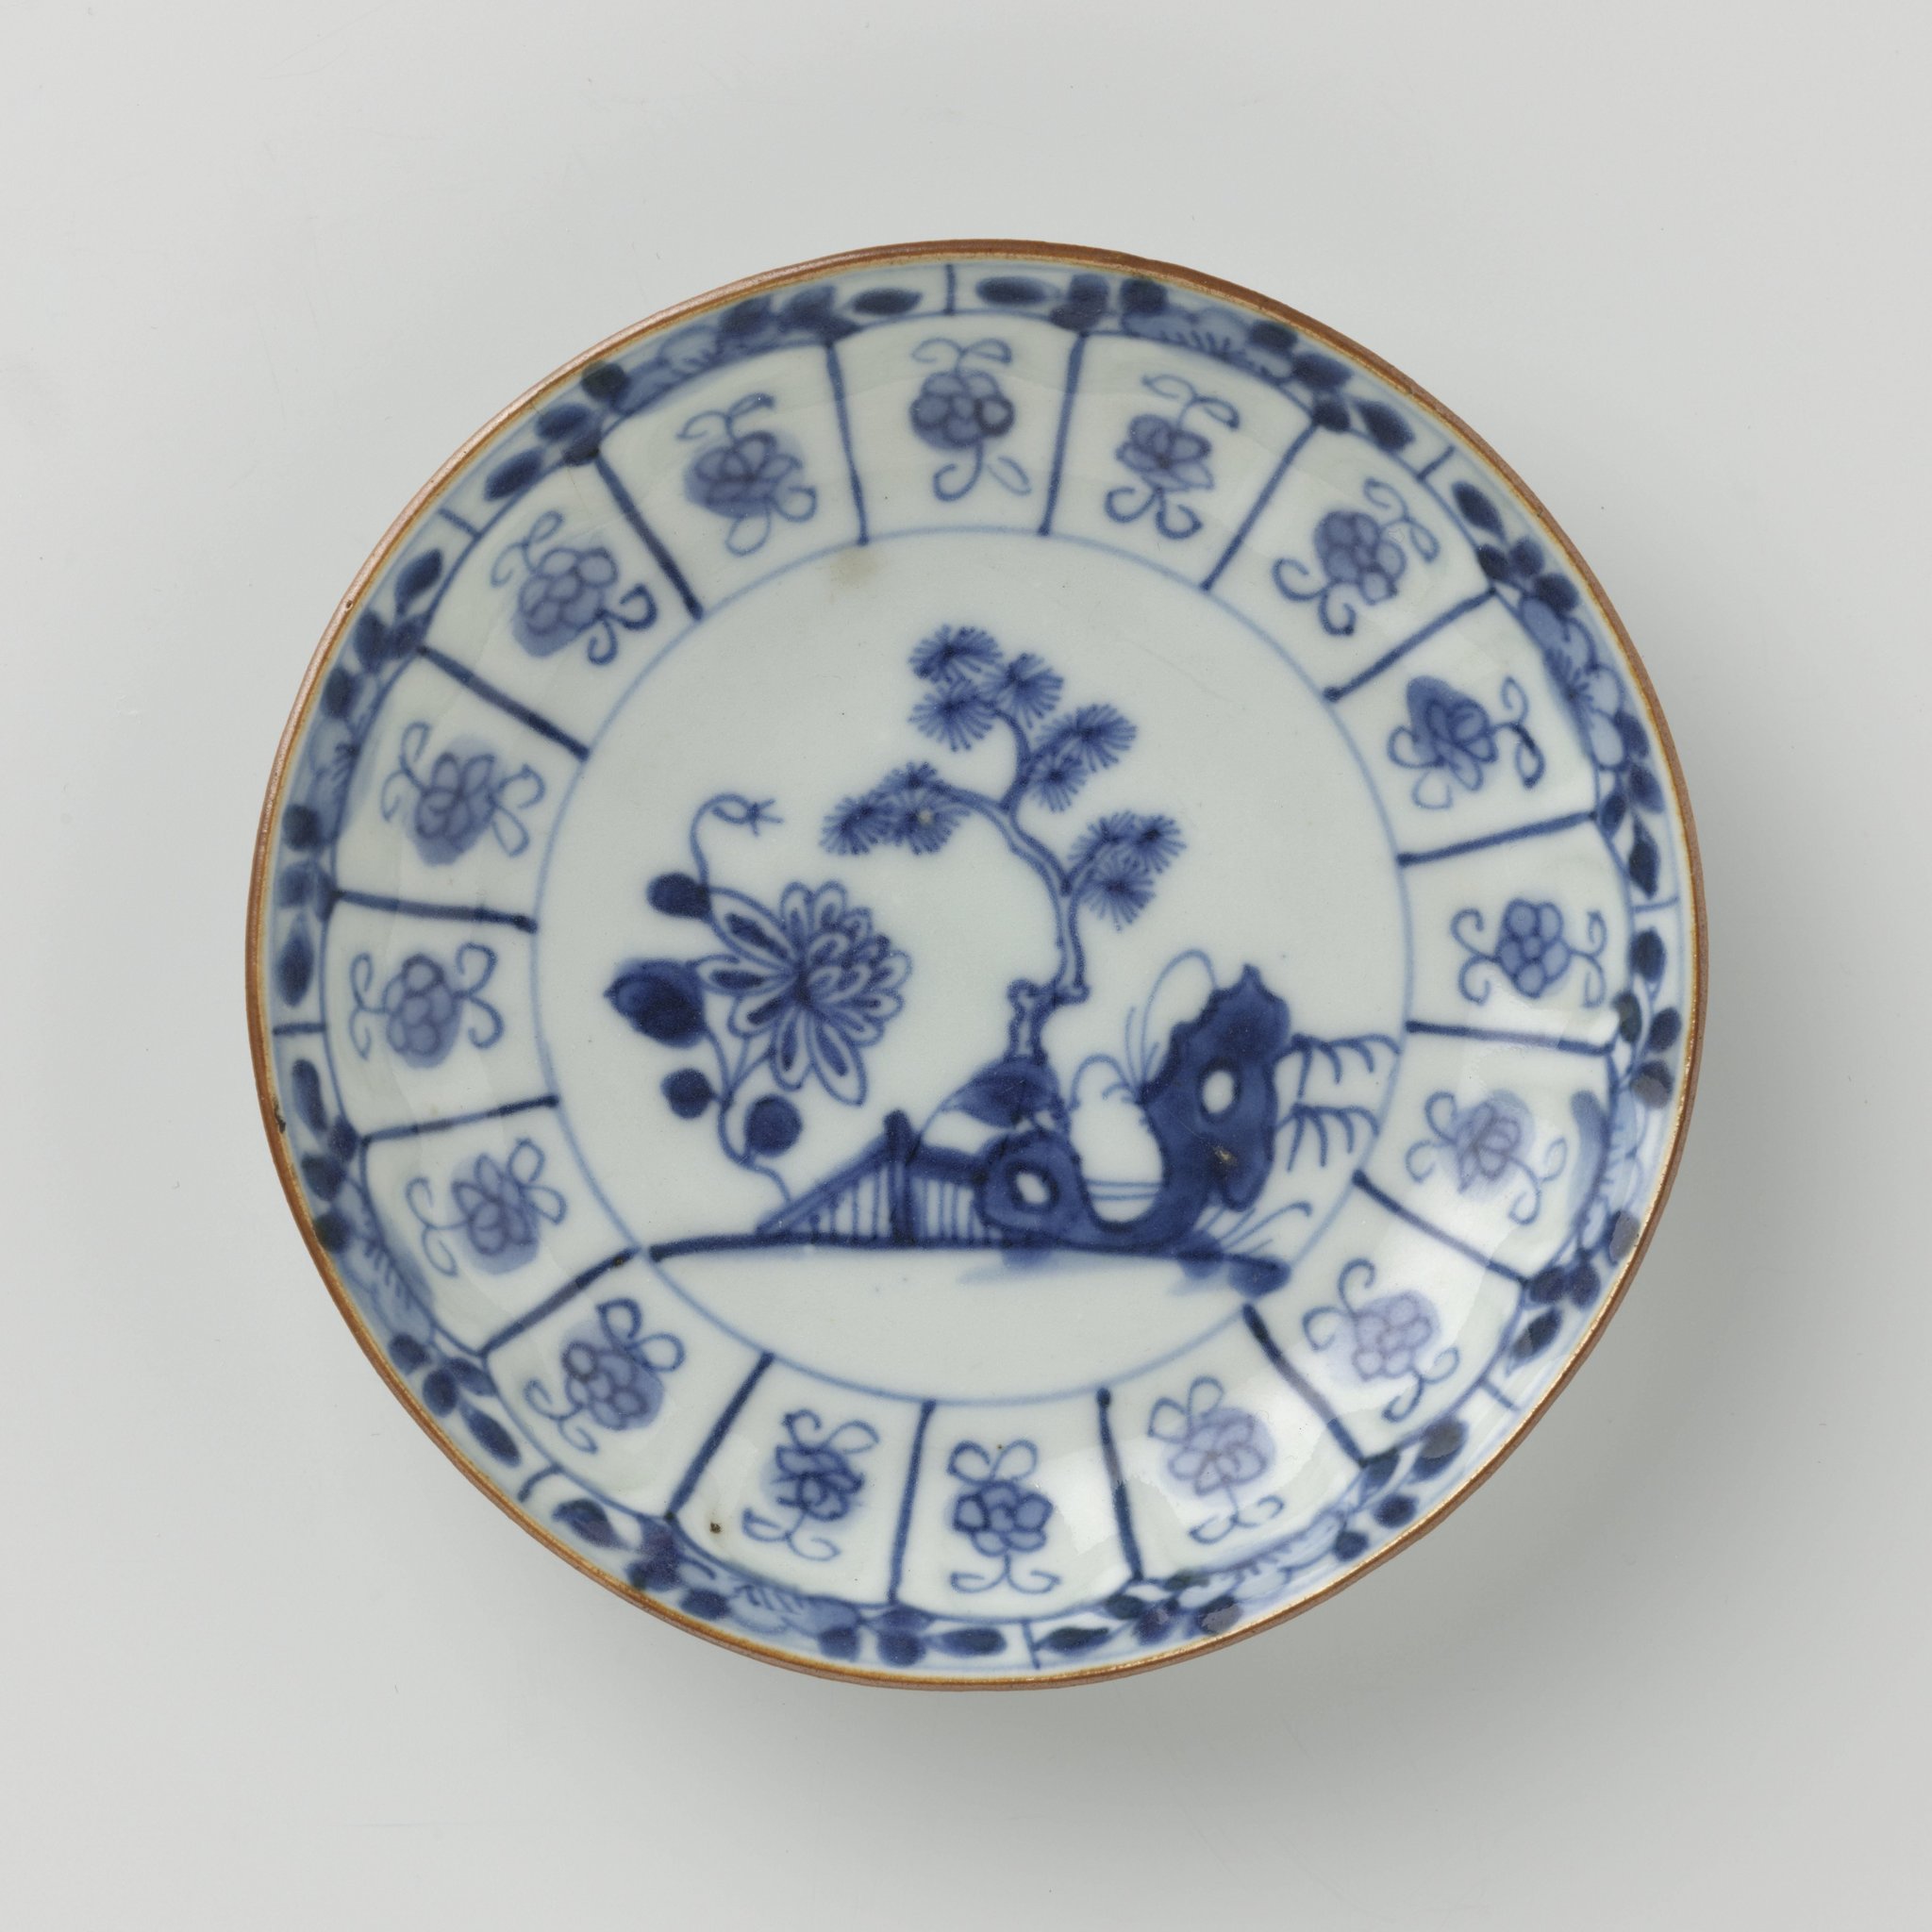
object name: platter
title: Saucer-dish with flowering plants, a rock and stylized flower sprays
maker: Anonymous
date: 1740-1760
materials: cobalt, glaze, paint, porcelain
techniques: firing, turning, vitrification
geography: china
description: Schotel van porselein, met ronde, gelobde wand, beschilderd in onderglazuur blauw. Op het plat een medaillon met bloeiende planten (pijnboom, lotus) achter een hek bij een rots; om het medaillon bloembladvormige vakken gemodelleerd in de wand gevuld met een gestileerde bloemtak. De rand is verdeeld in vakken met een bloemrank. Op de achterzijde twee takken. Een barst in de wand. Blauw-wit.